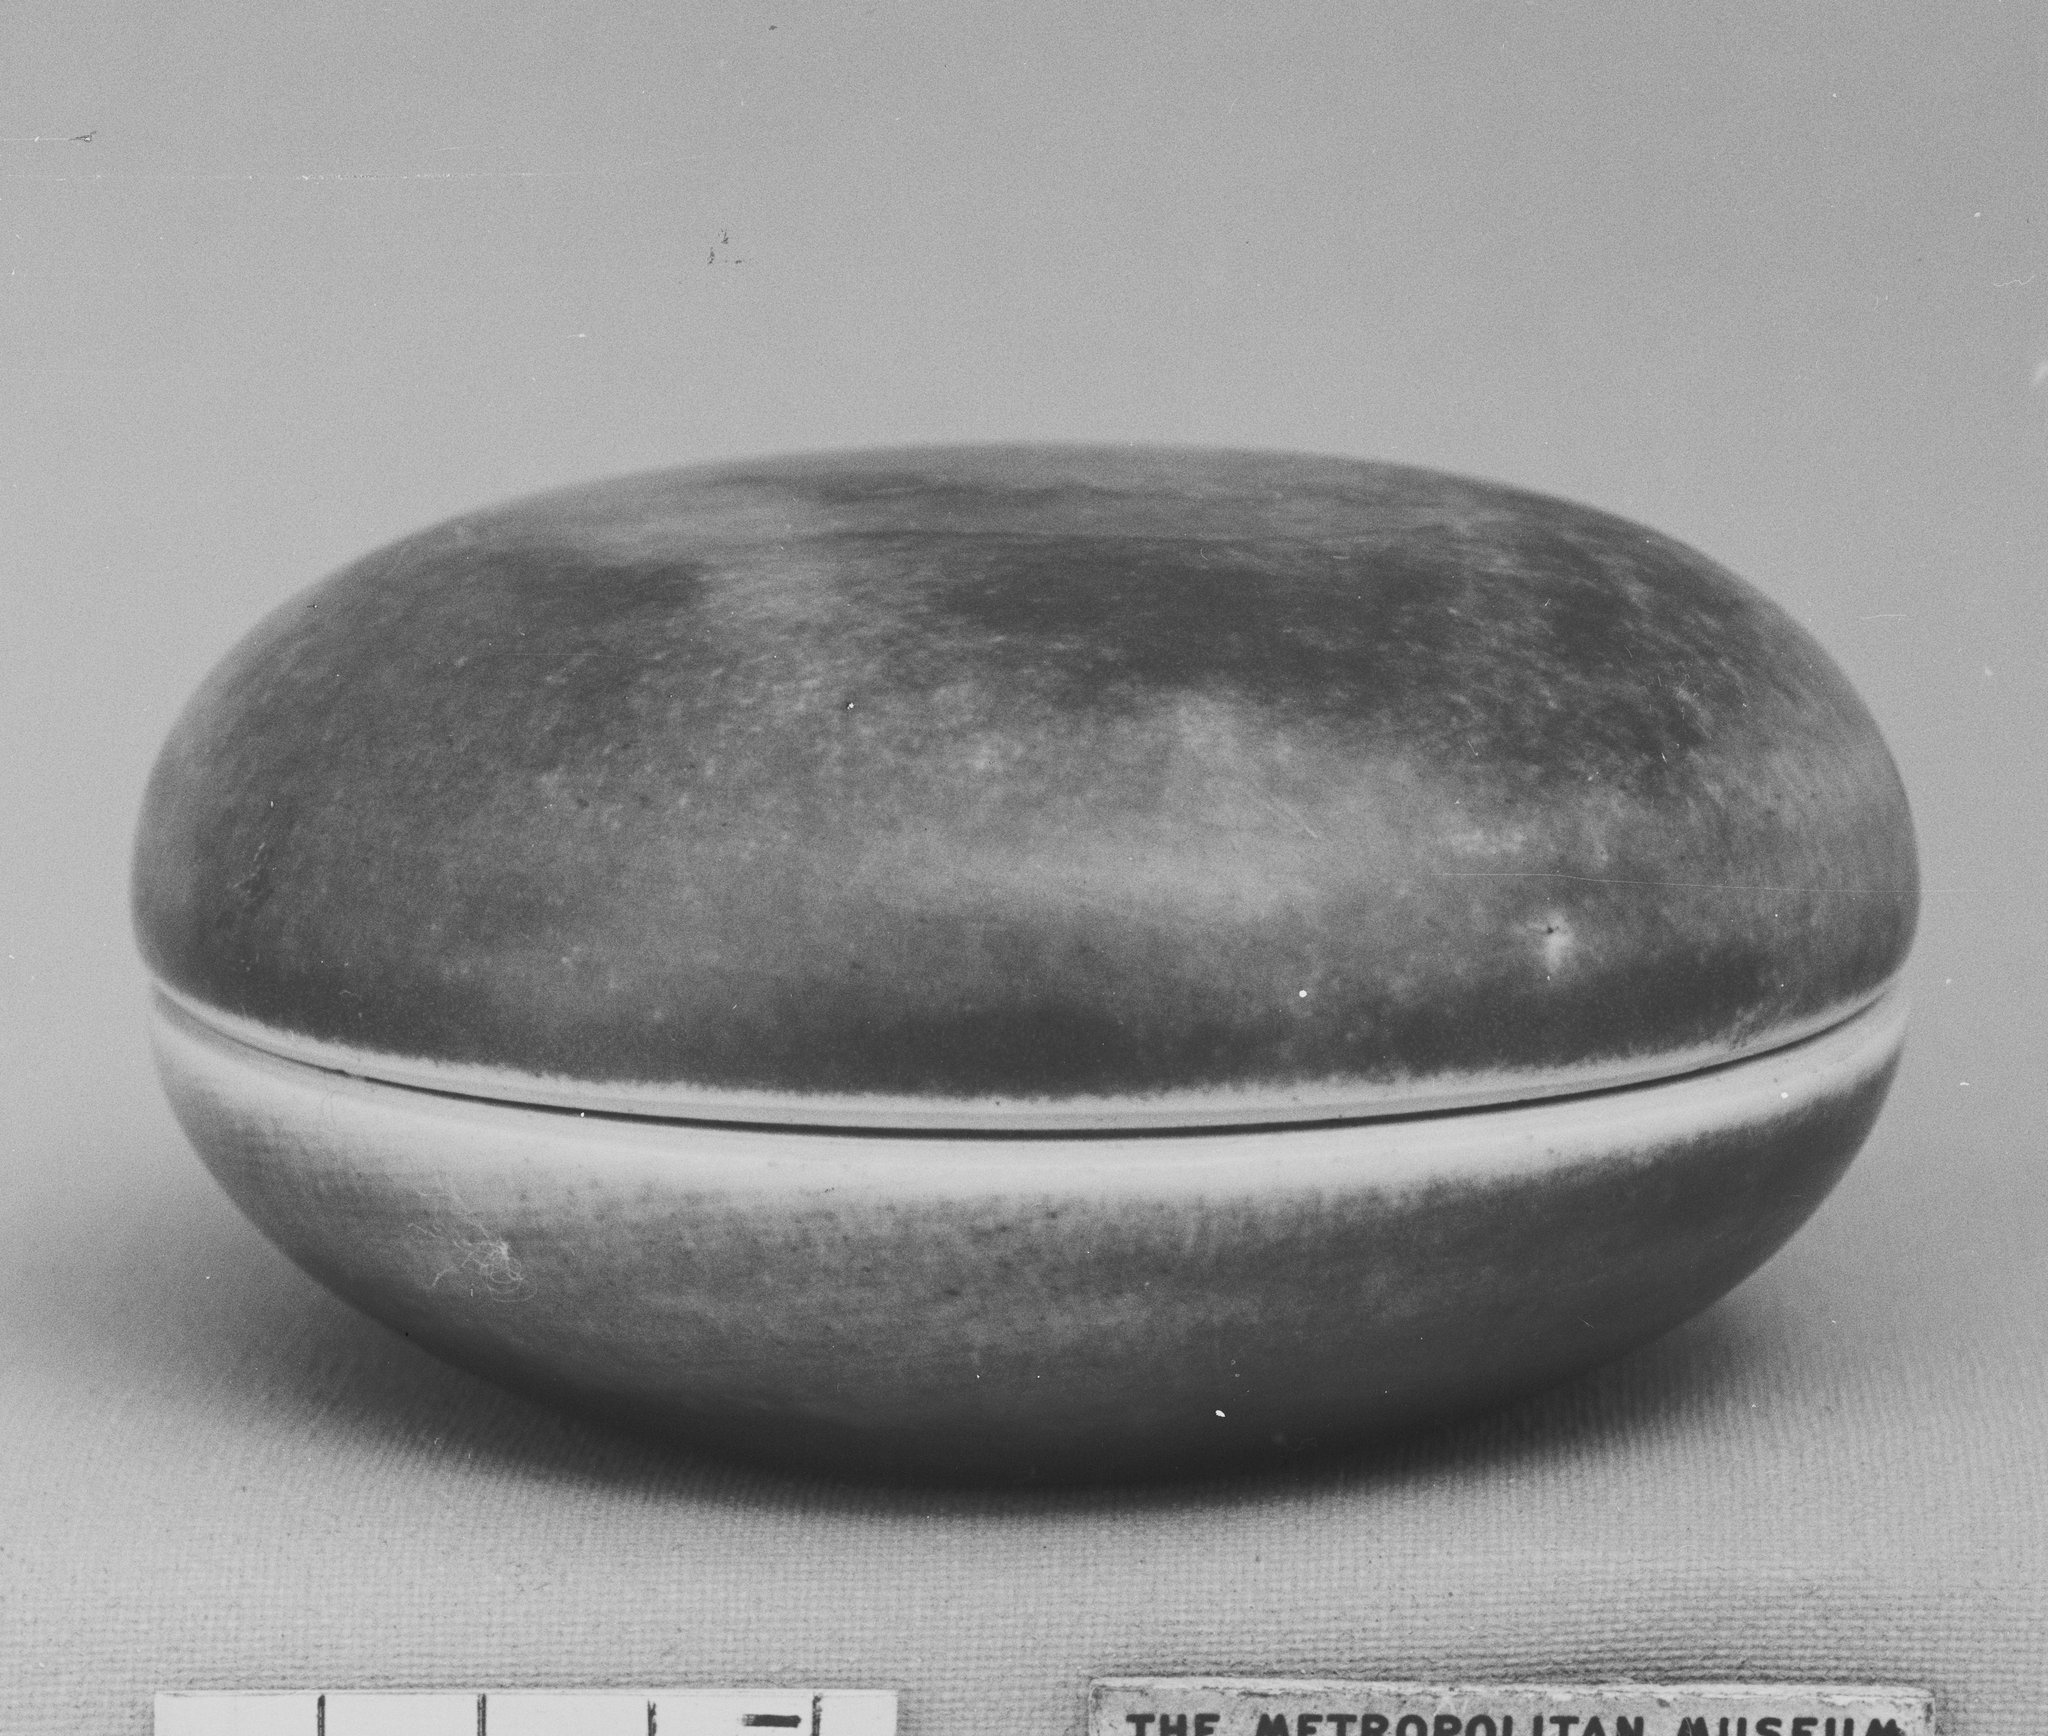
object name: rouge box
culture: chinese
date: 1662-1722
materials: porcelain